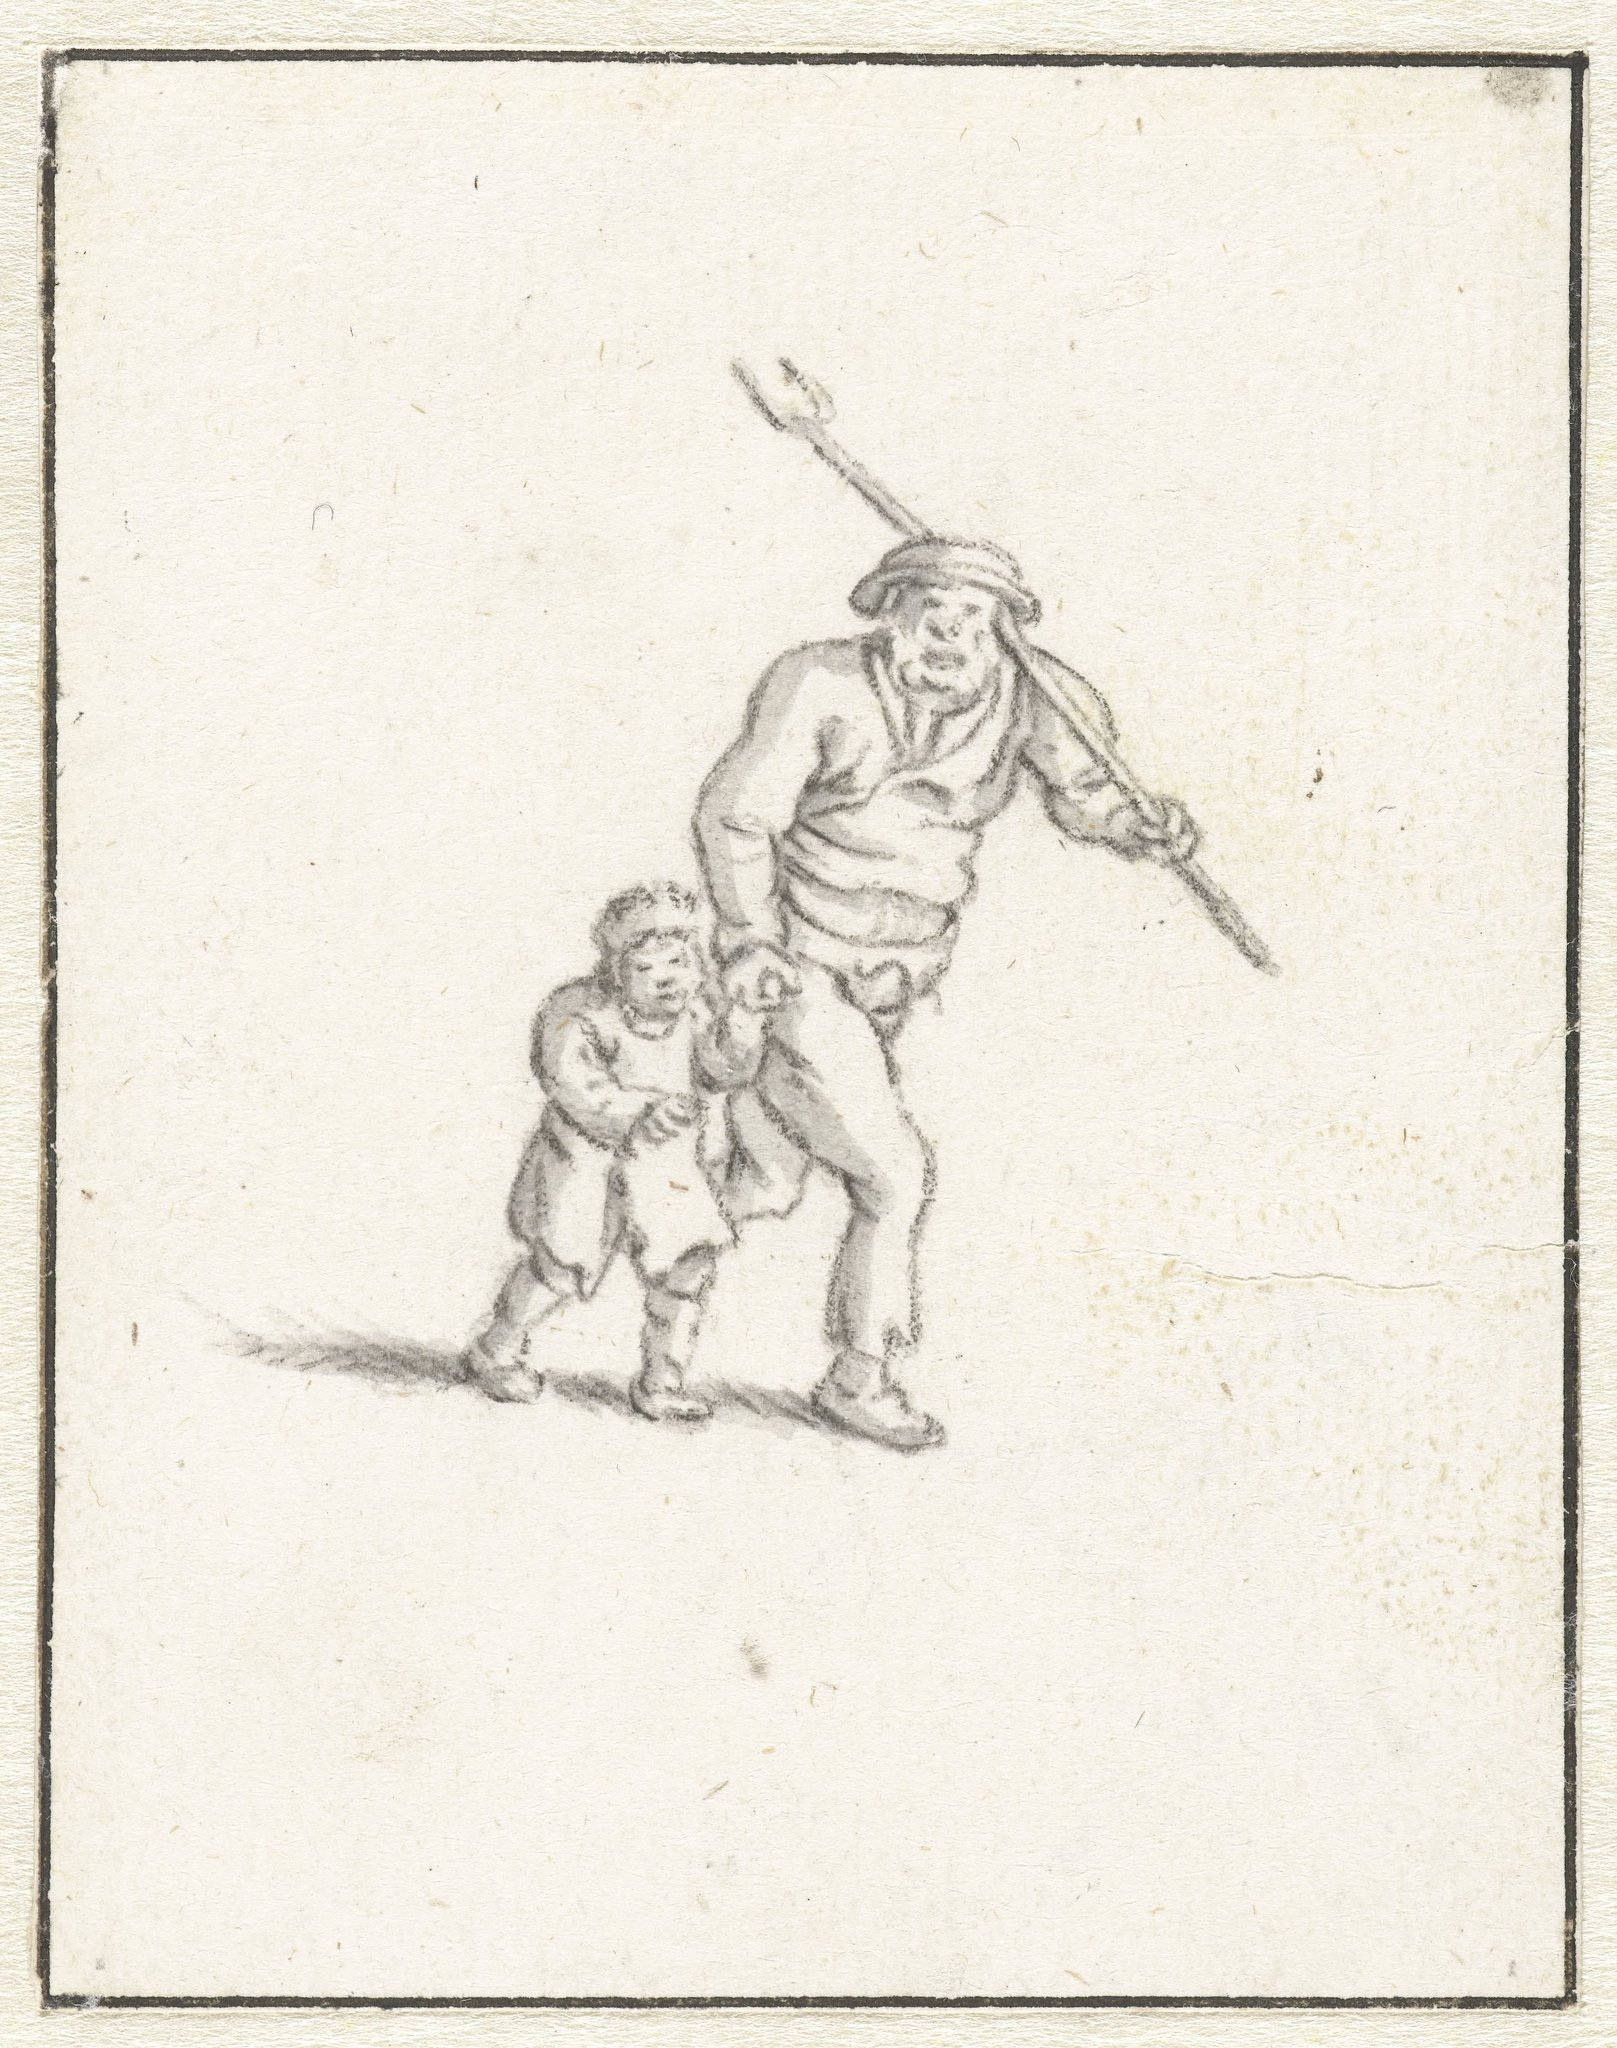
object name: drawing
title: Man en een jongetje, naar rechts lopend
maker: herman saftleven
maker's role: draughtsman, painter, print maker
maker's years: 1609-1685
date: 1619-1685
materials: chalk, paper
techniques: brush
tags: boy (child between toddler and youth), walking